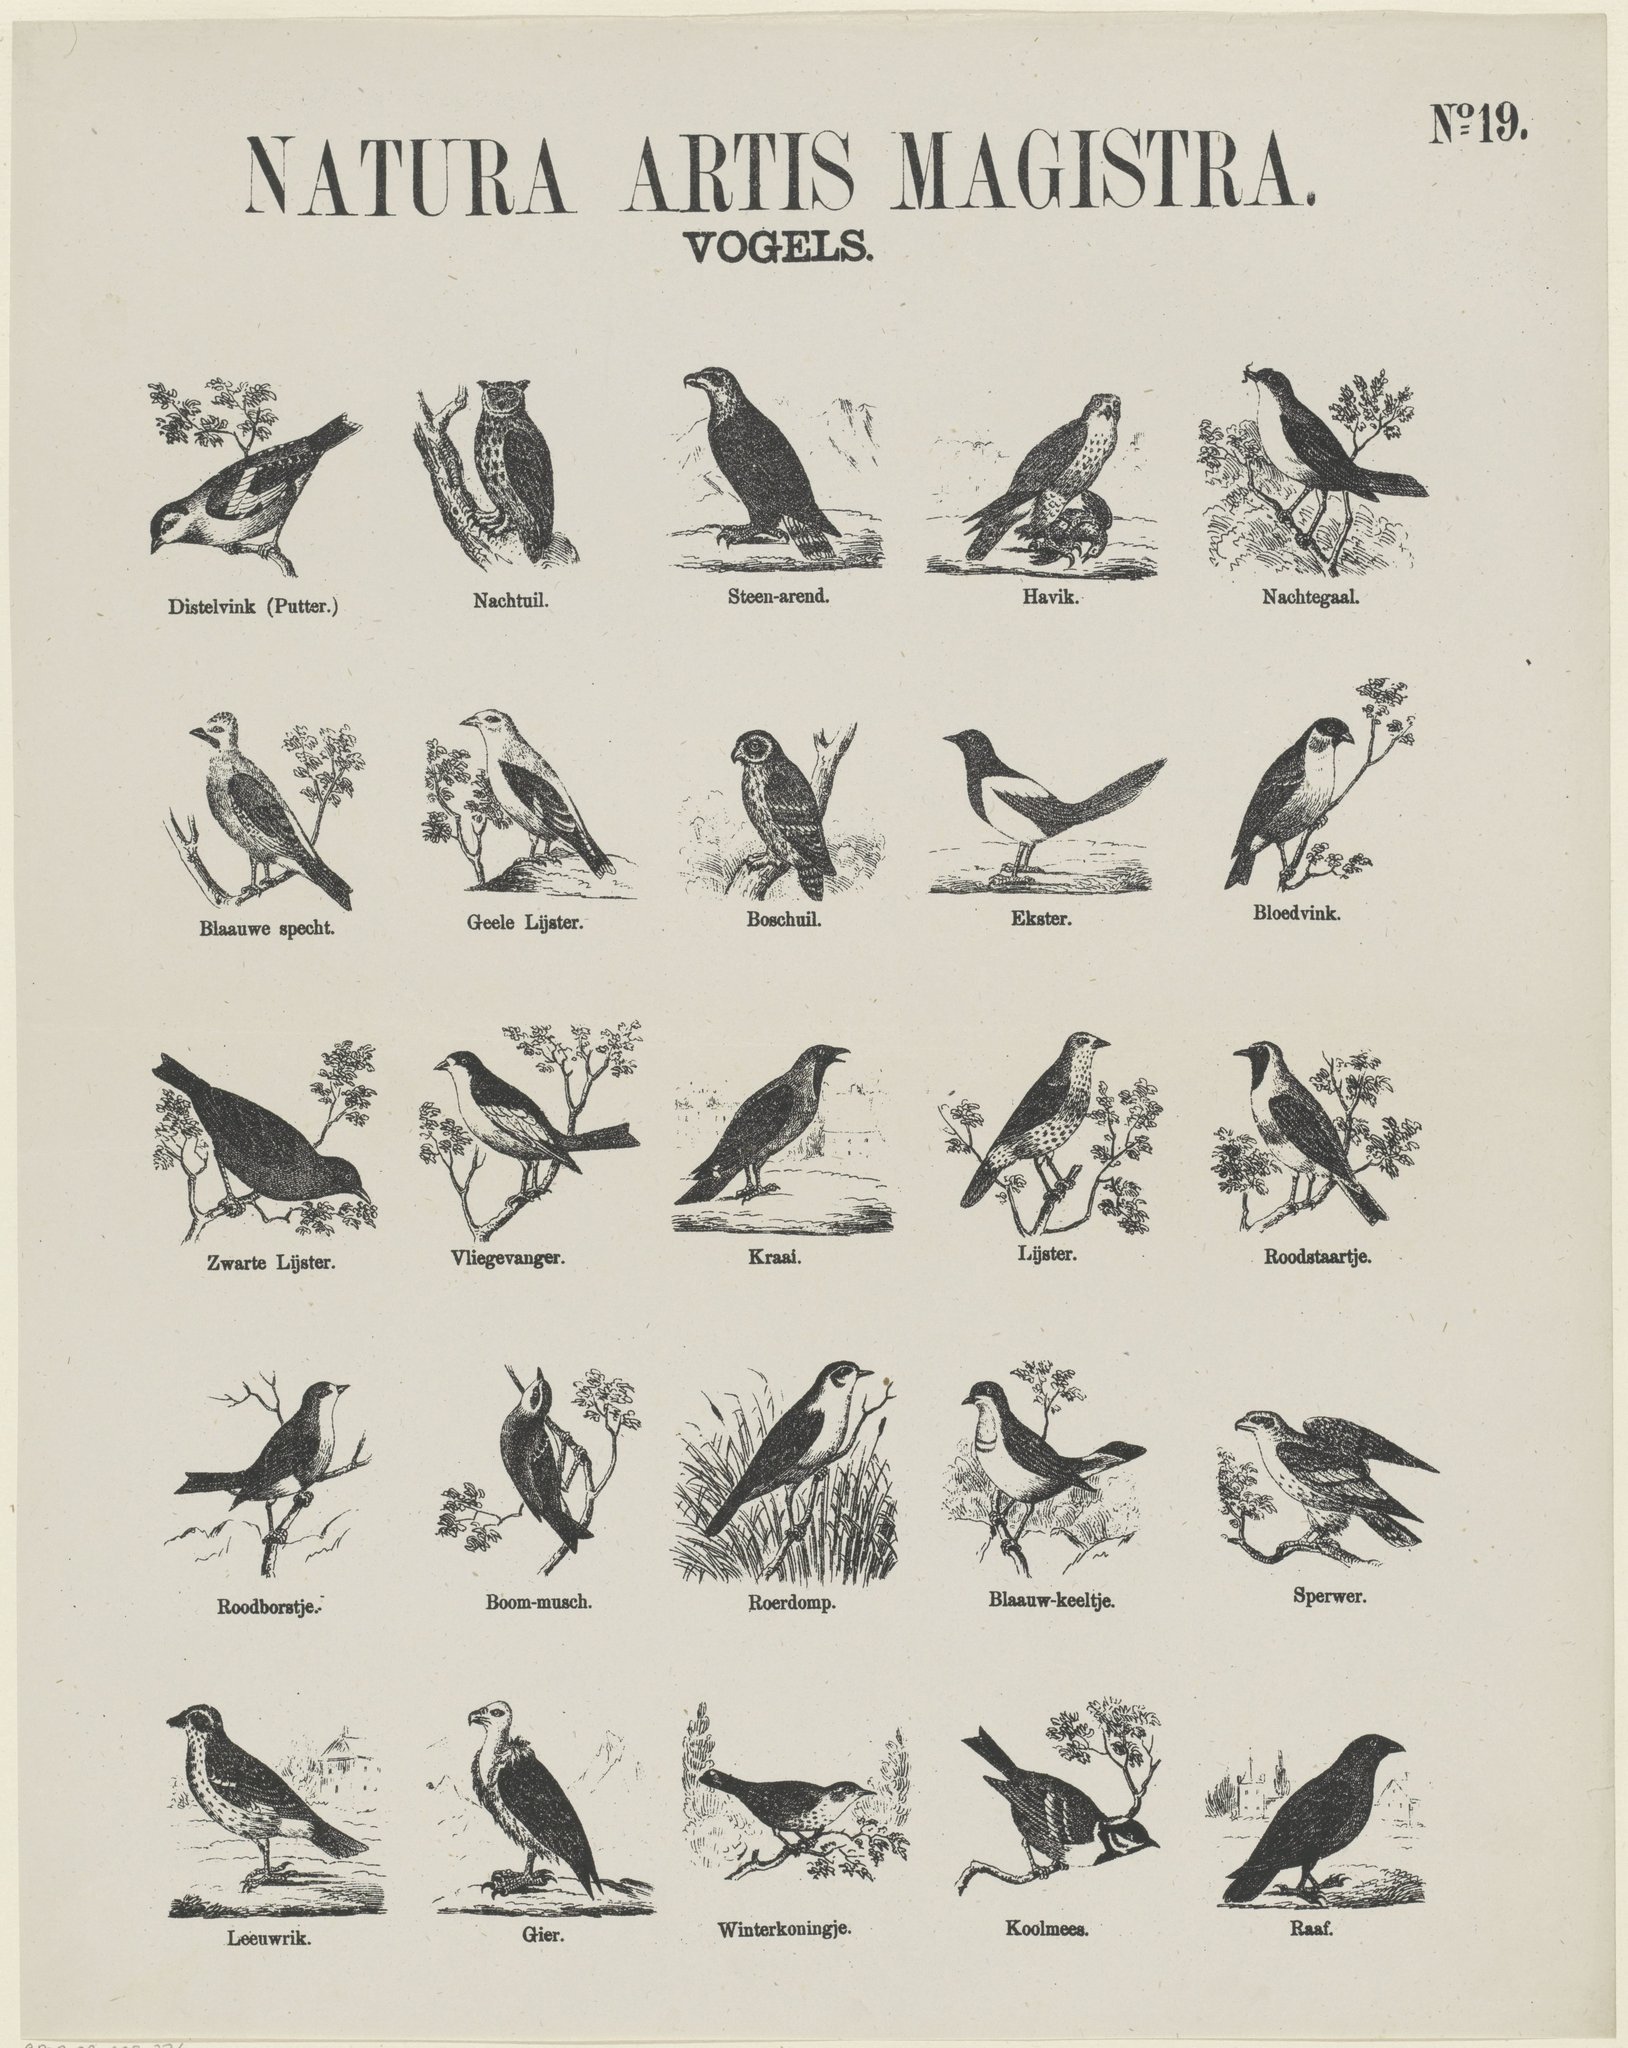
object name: print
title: Natura artis magistra / vogels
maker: Anonymous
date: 1873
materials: paper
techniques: letterpress printing, lithograph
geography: amsterdam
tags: birds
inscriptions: collector's mark: Lugt 2760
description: Blad met 25 voorstellingen van vogels, waaronder een distelvink, een ekster, een lijster, een roodborstje en een koolmees. Onder elke afbeelding een onderschrift. Genummerd rechtsboven: No. 19.